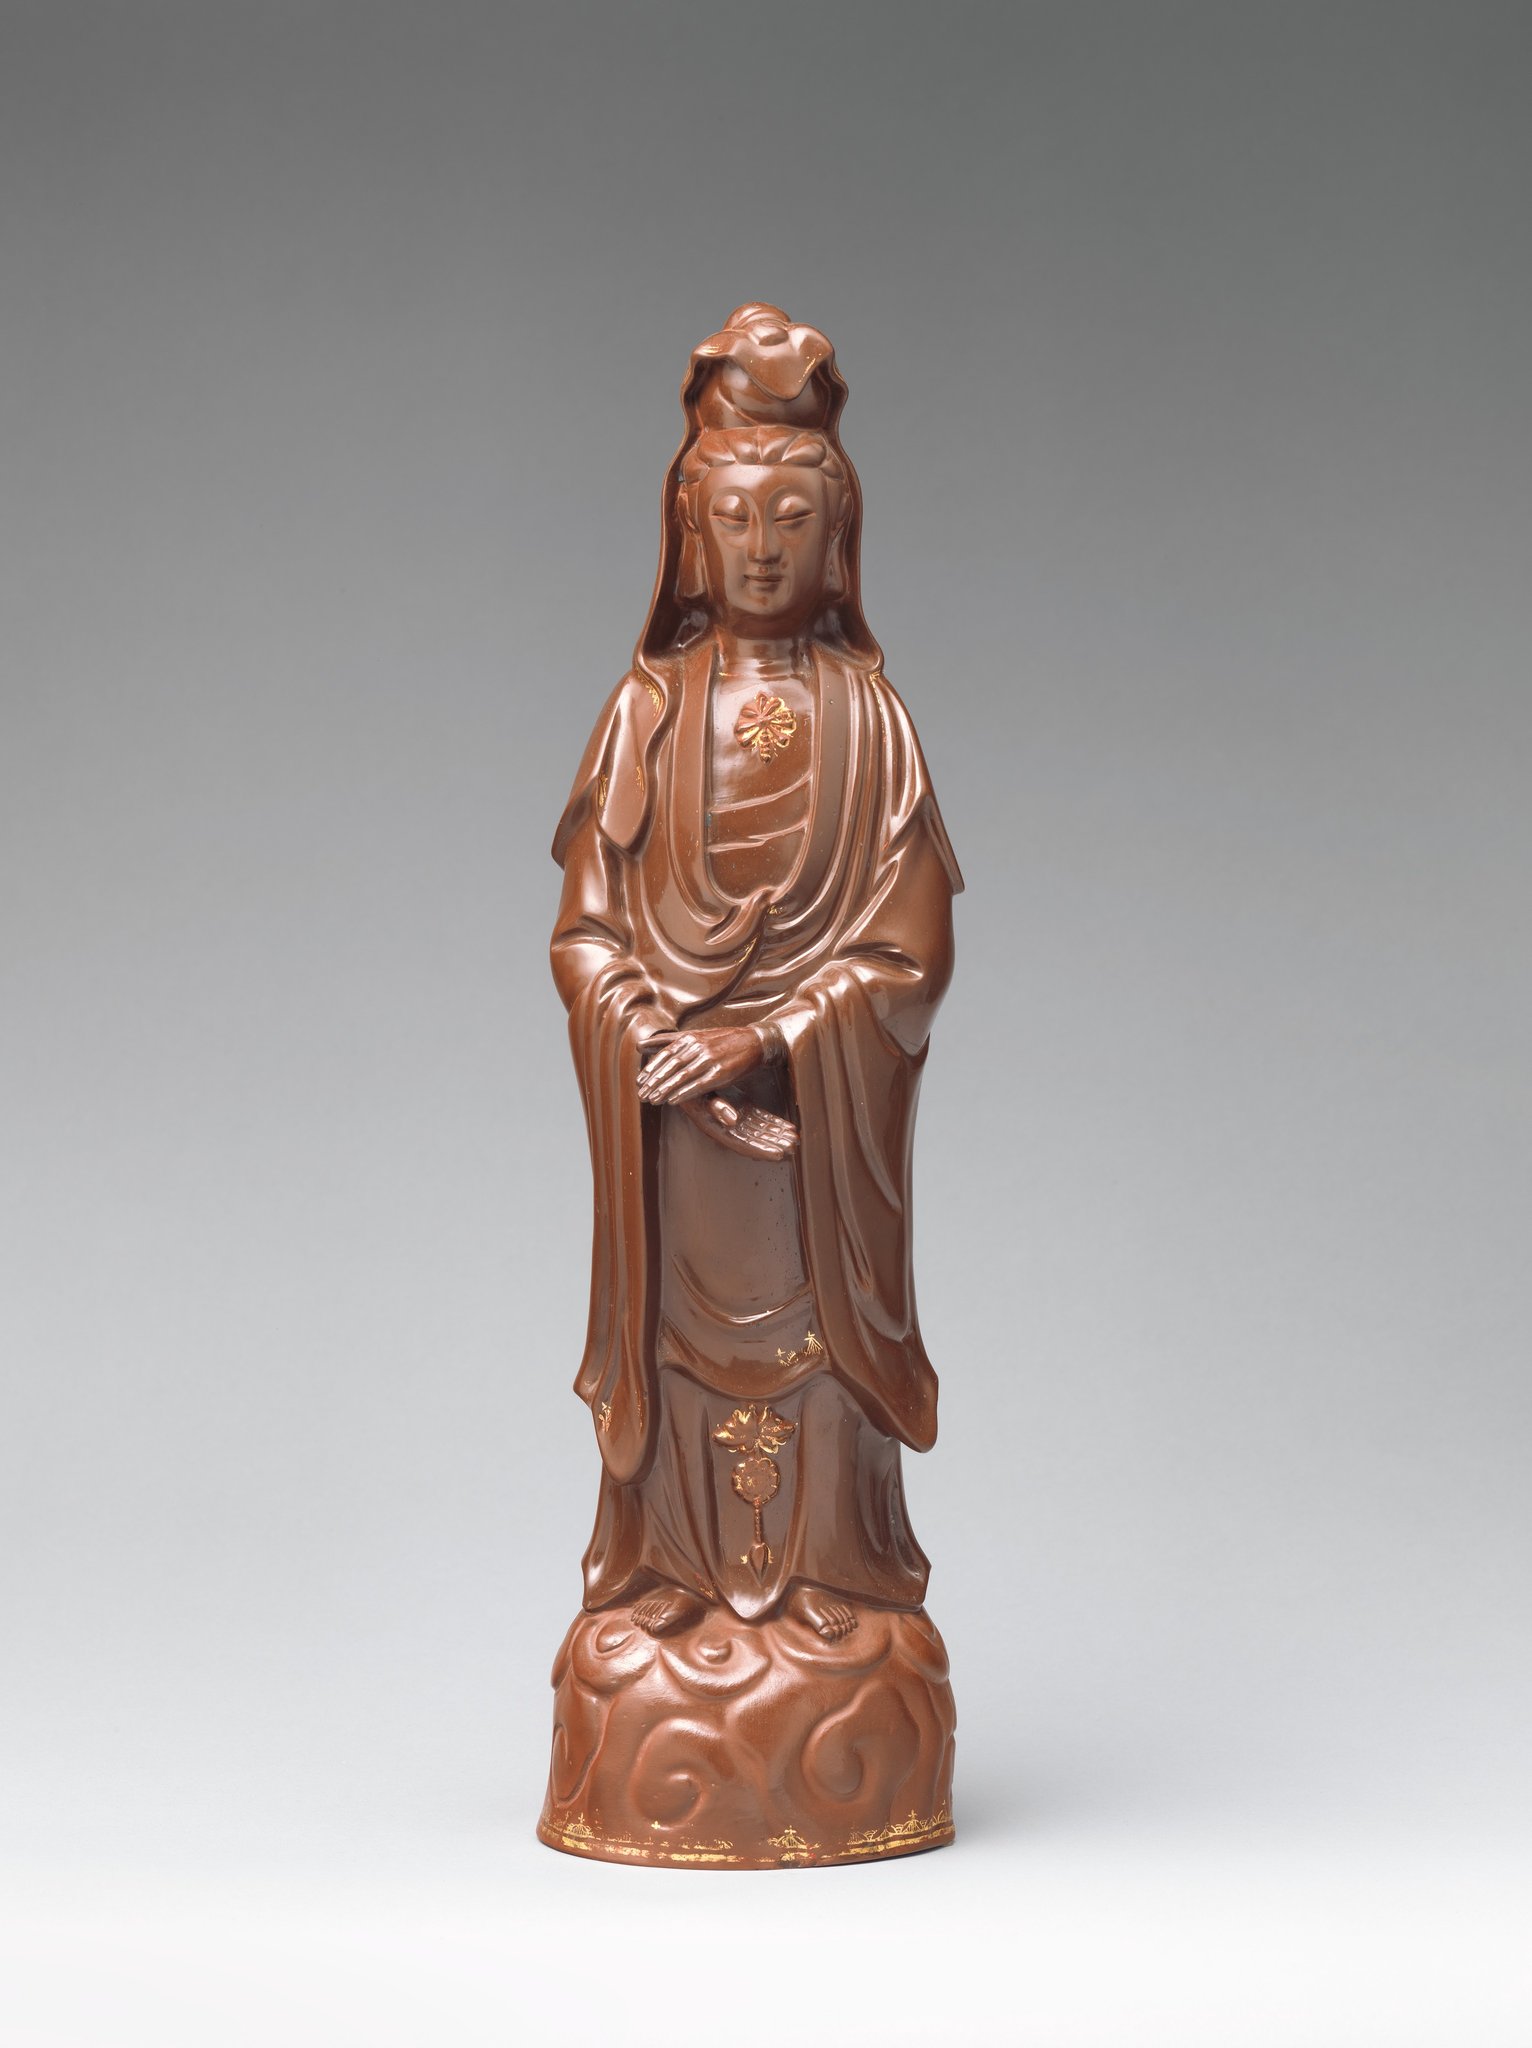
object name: figure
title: Guanyin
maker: meissen manufactory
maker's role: manufactory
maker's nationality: german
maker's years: 1710-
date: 1710-1713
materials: stoneware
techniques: gilding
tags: buddhism,bodhisattvas